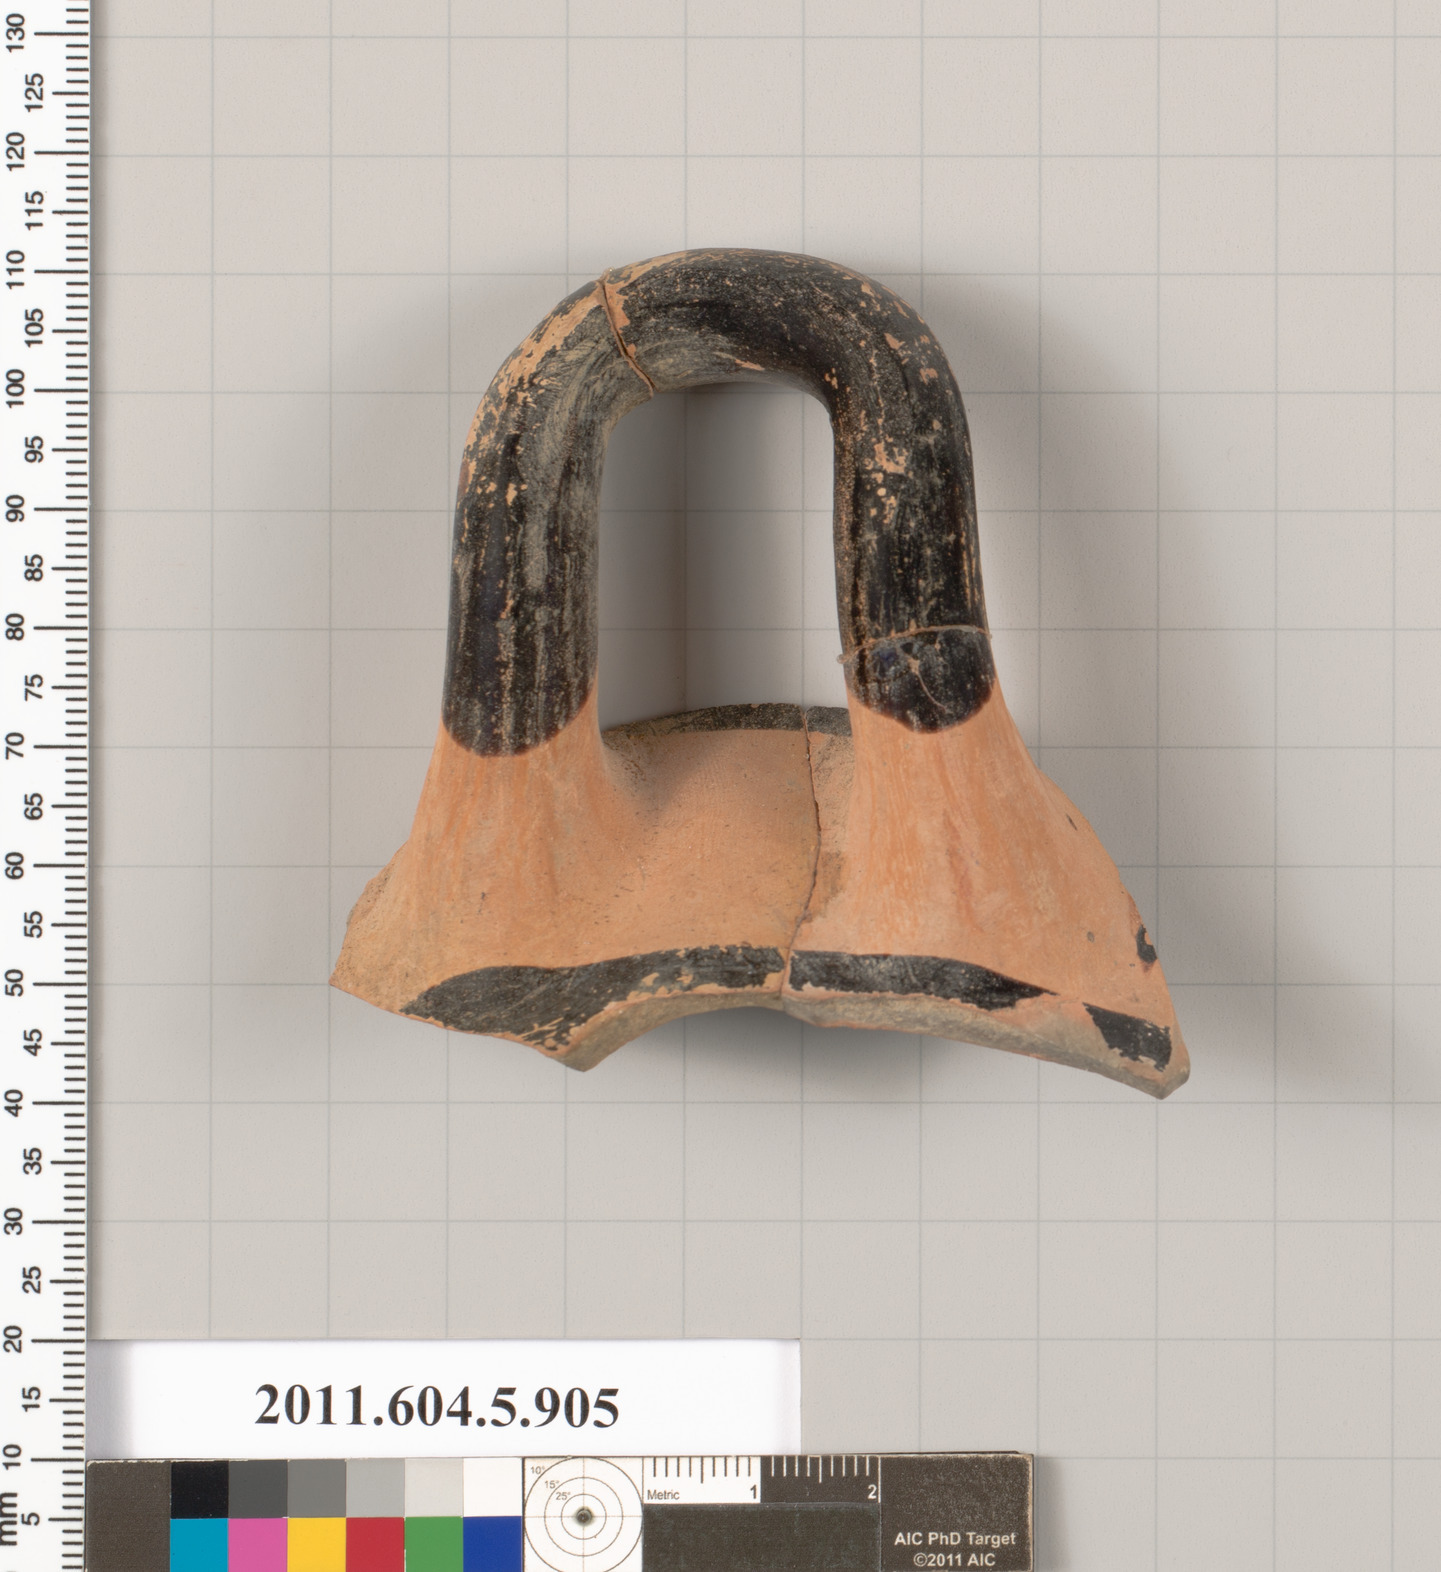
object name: kylix fragment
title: Terracotta fragment of a kylix (drinking cup)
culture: greek, attic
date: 600-401 BCE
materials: terracotta